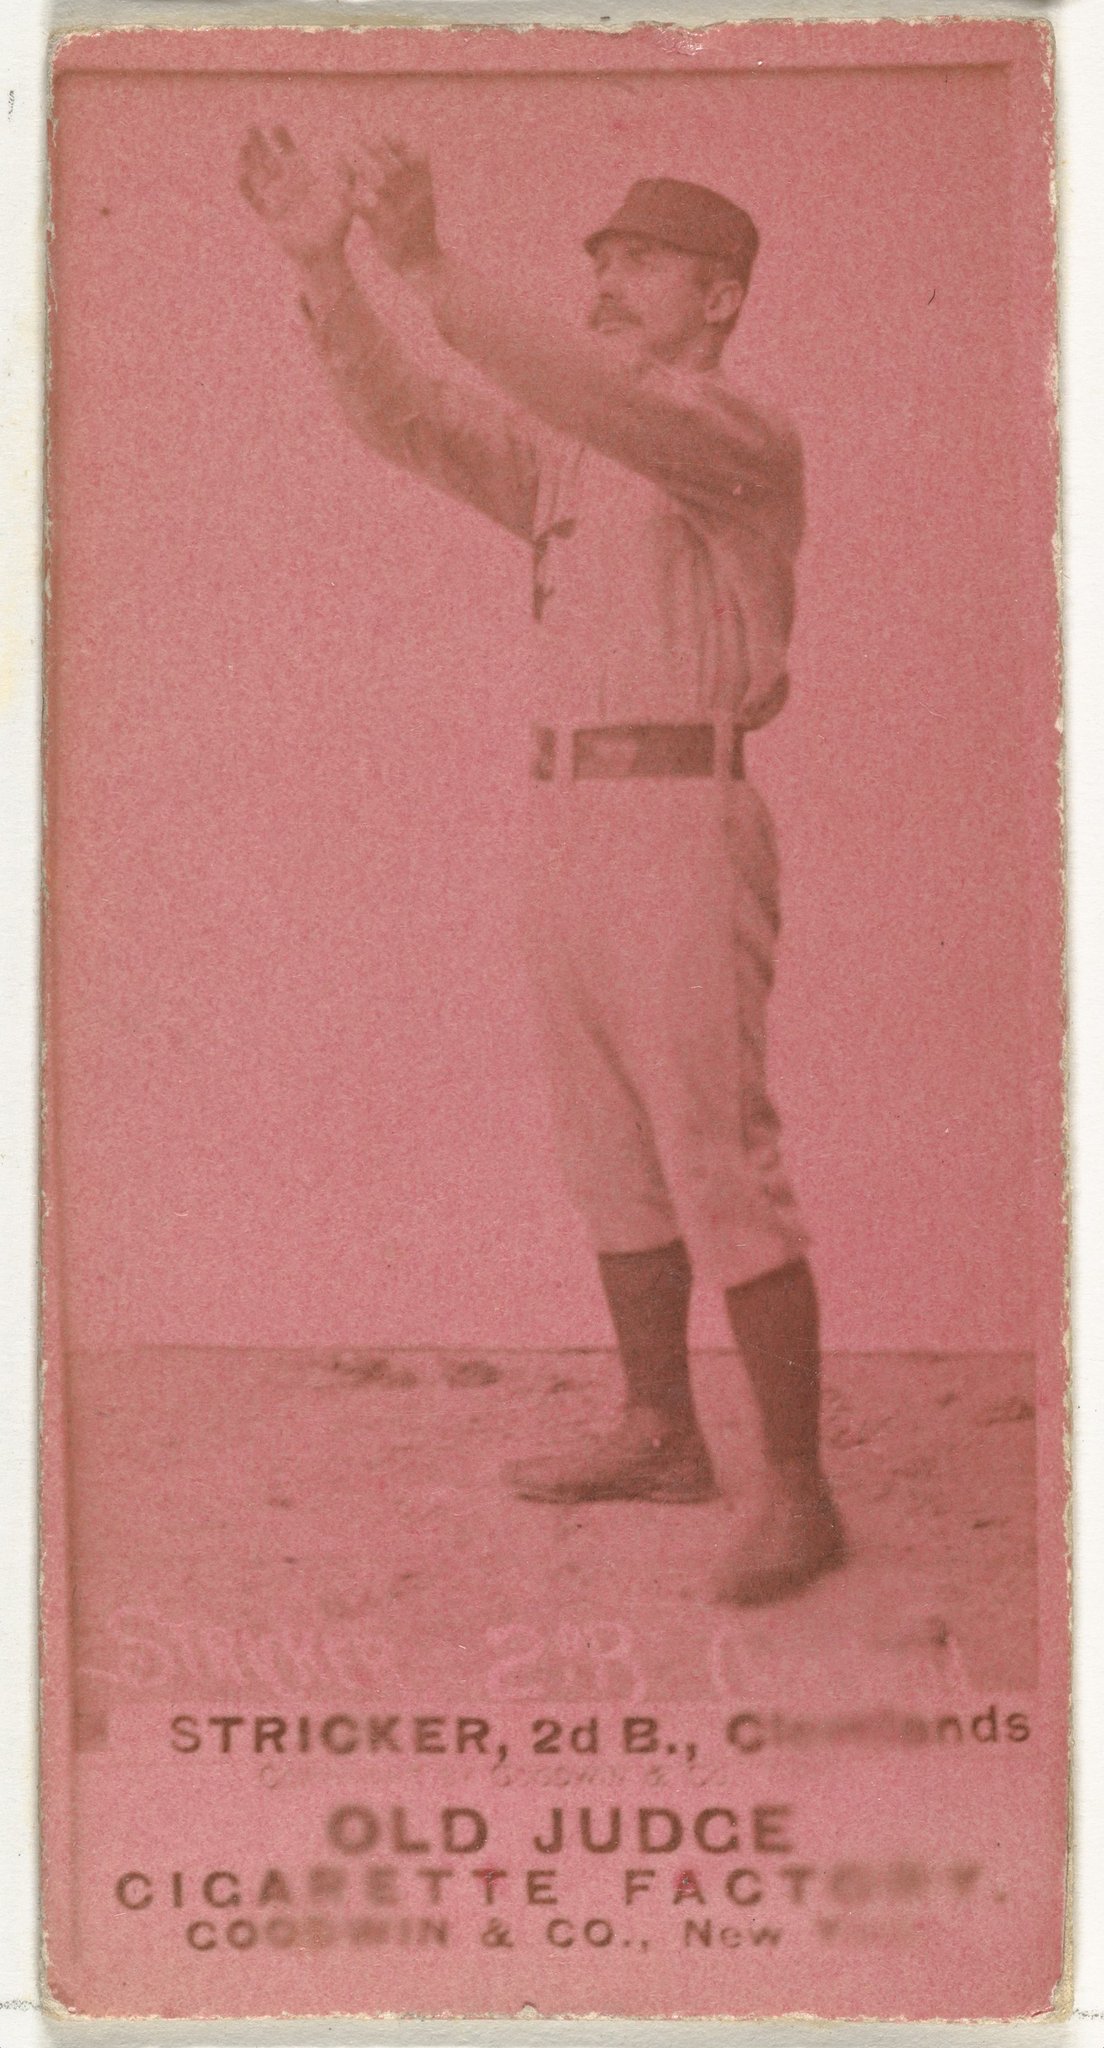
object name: baseball card, photograph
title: John A. "Cub" Stricker, 2nd Base, Cleveland, from the Old Judge series (N172) for Old Judge Cigarettes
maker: goodwin & company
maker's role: publisher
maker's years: 1850-1950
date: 1887-1890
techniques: albumen silver print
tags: men,portraits,baseball,athletes